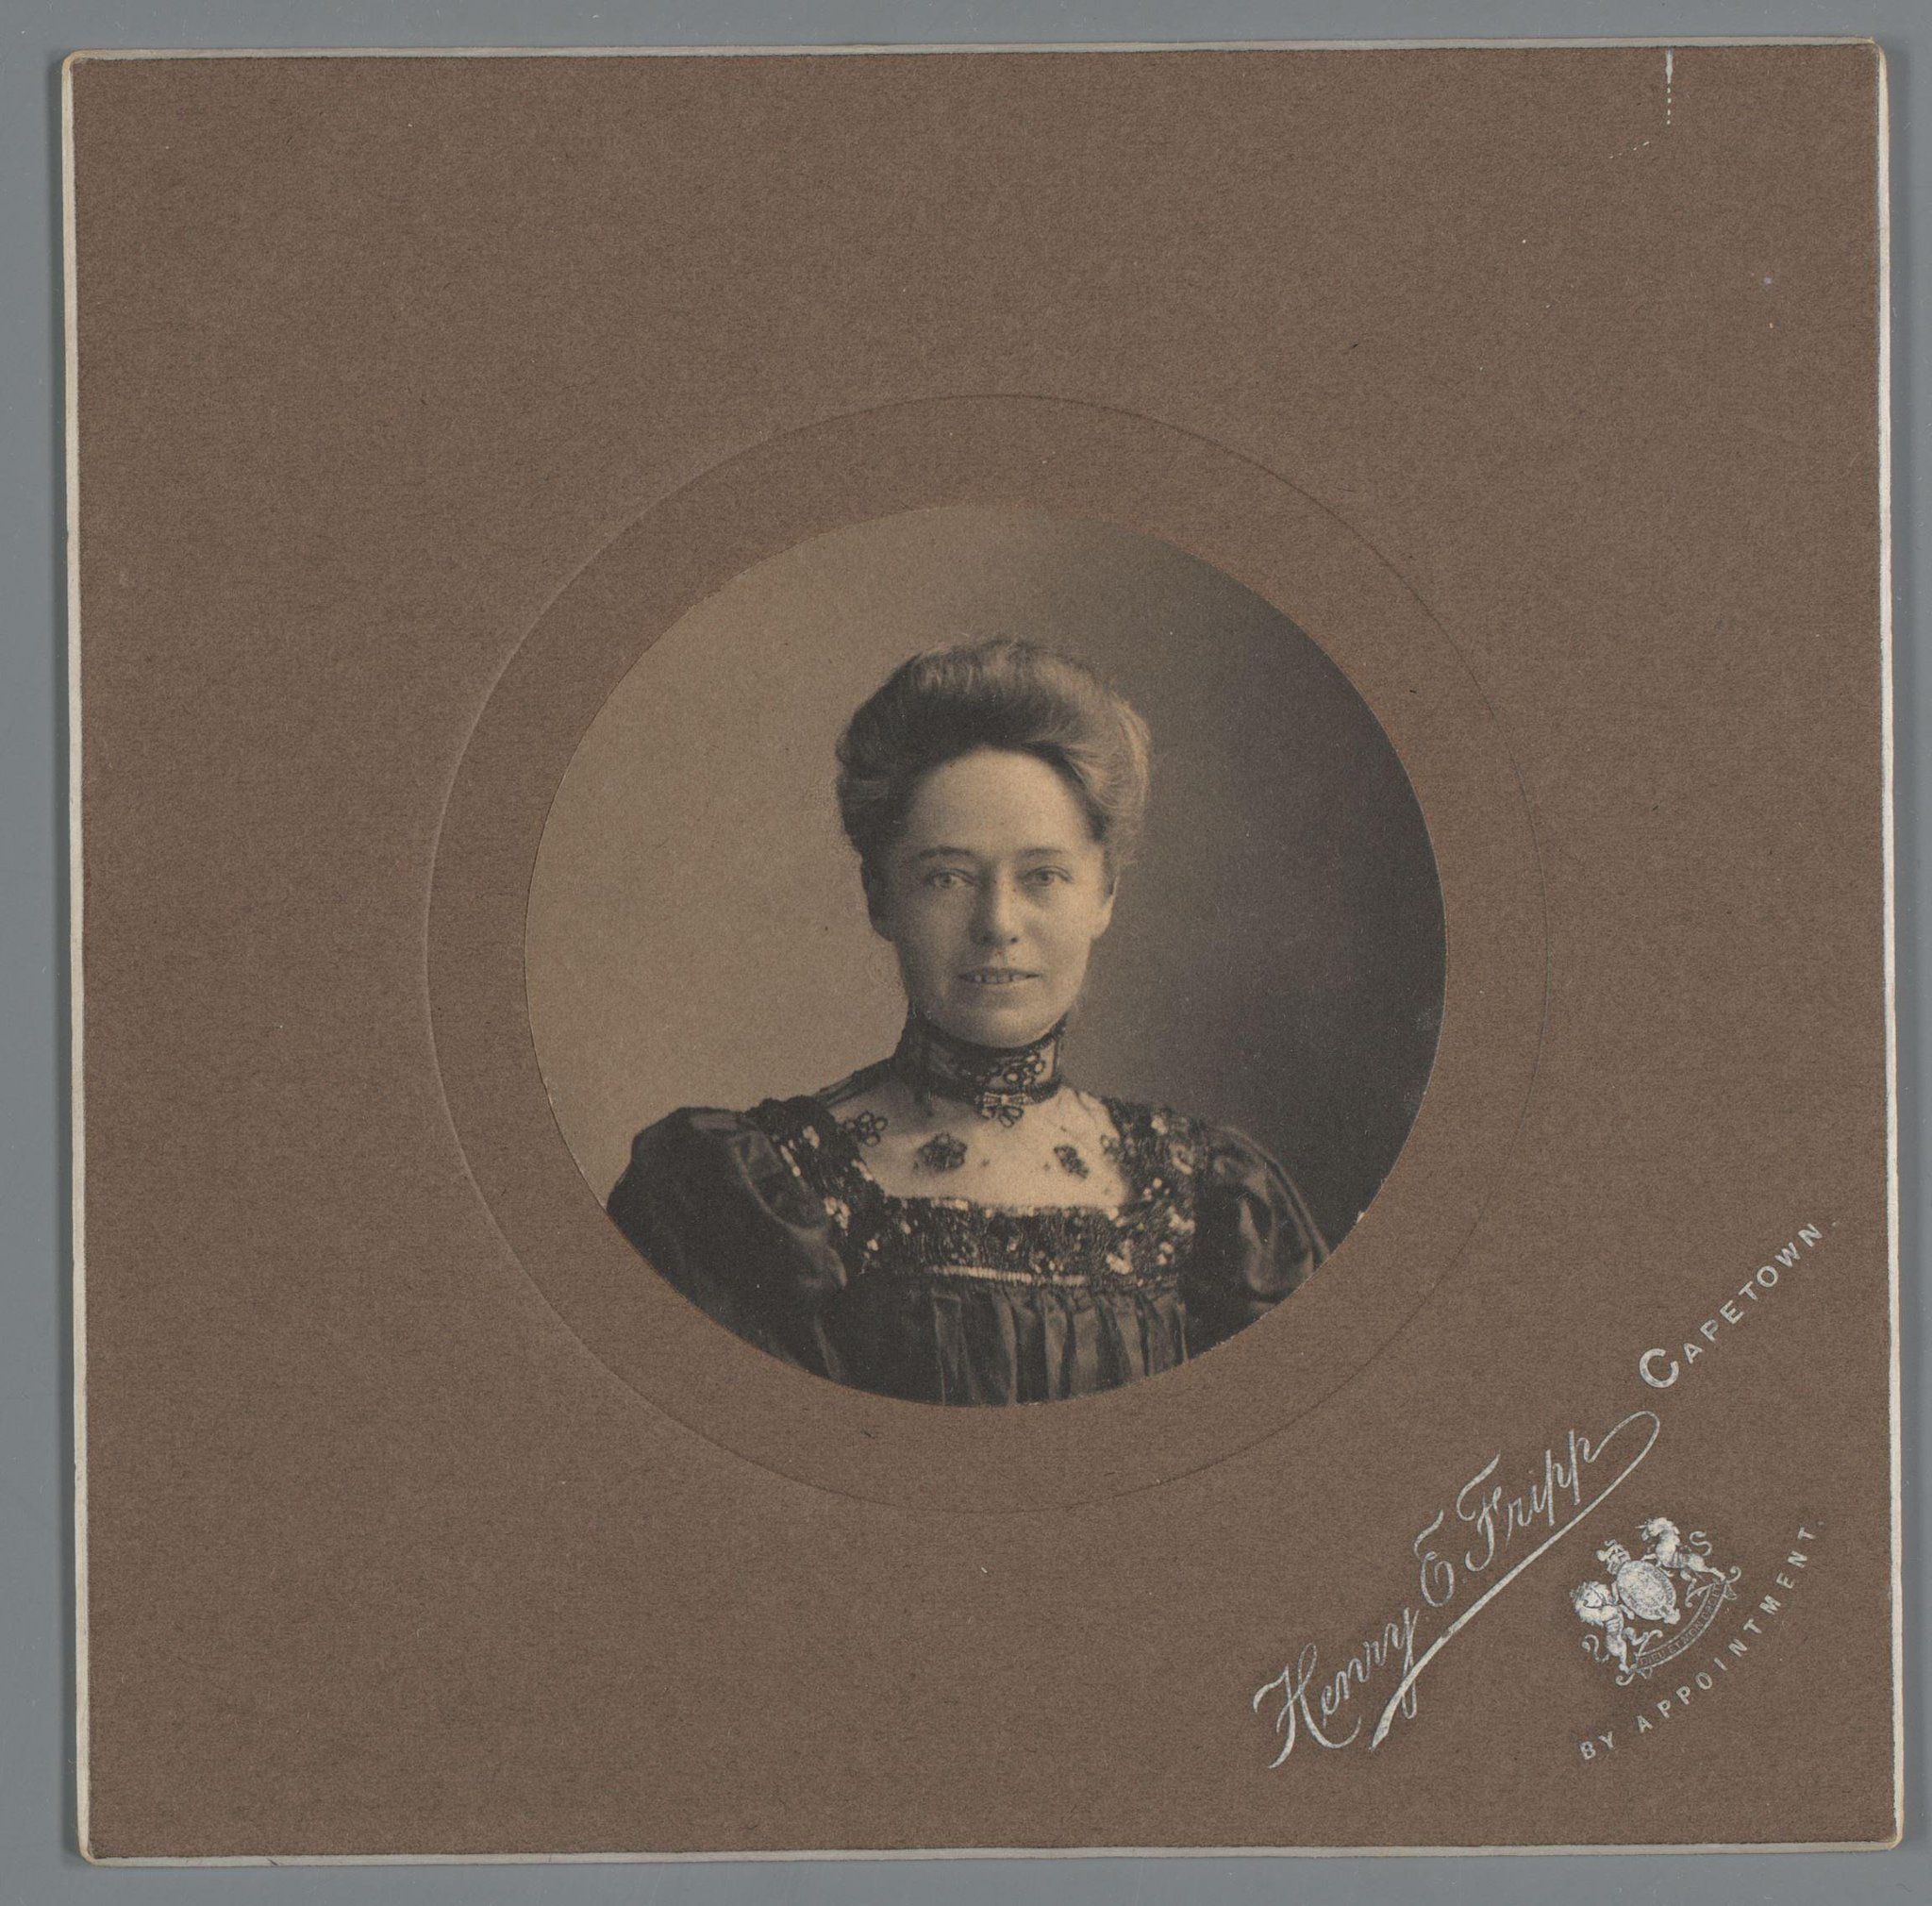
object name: photograph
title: Portret van Anna Gesiena Jonker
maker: henry edward fripp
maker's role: fotograaf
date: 1910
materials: cardboard, photographic support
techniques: platinum process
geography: cape town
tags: historical persons